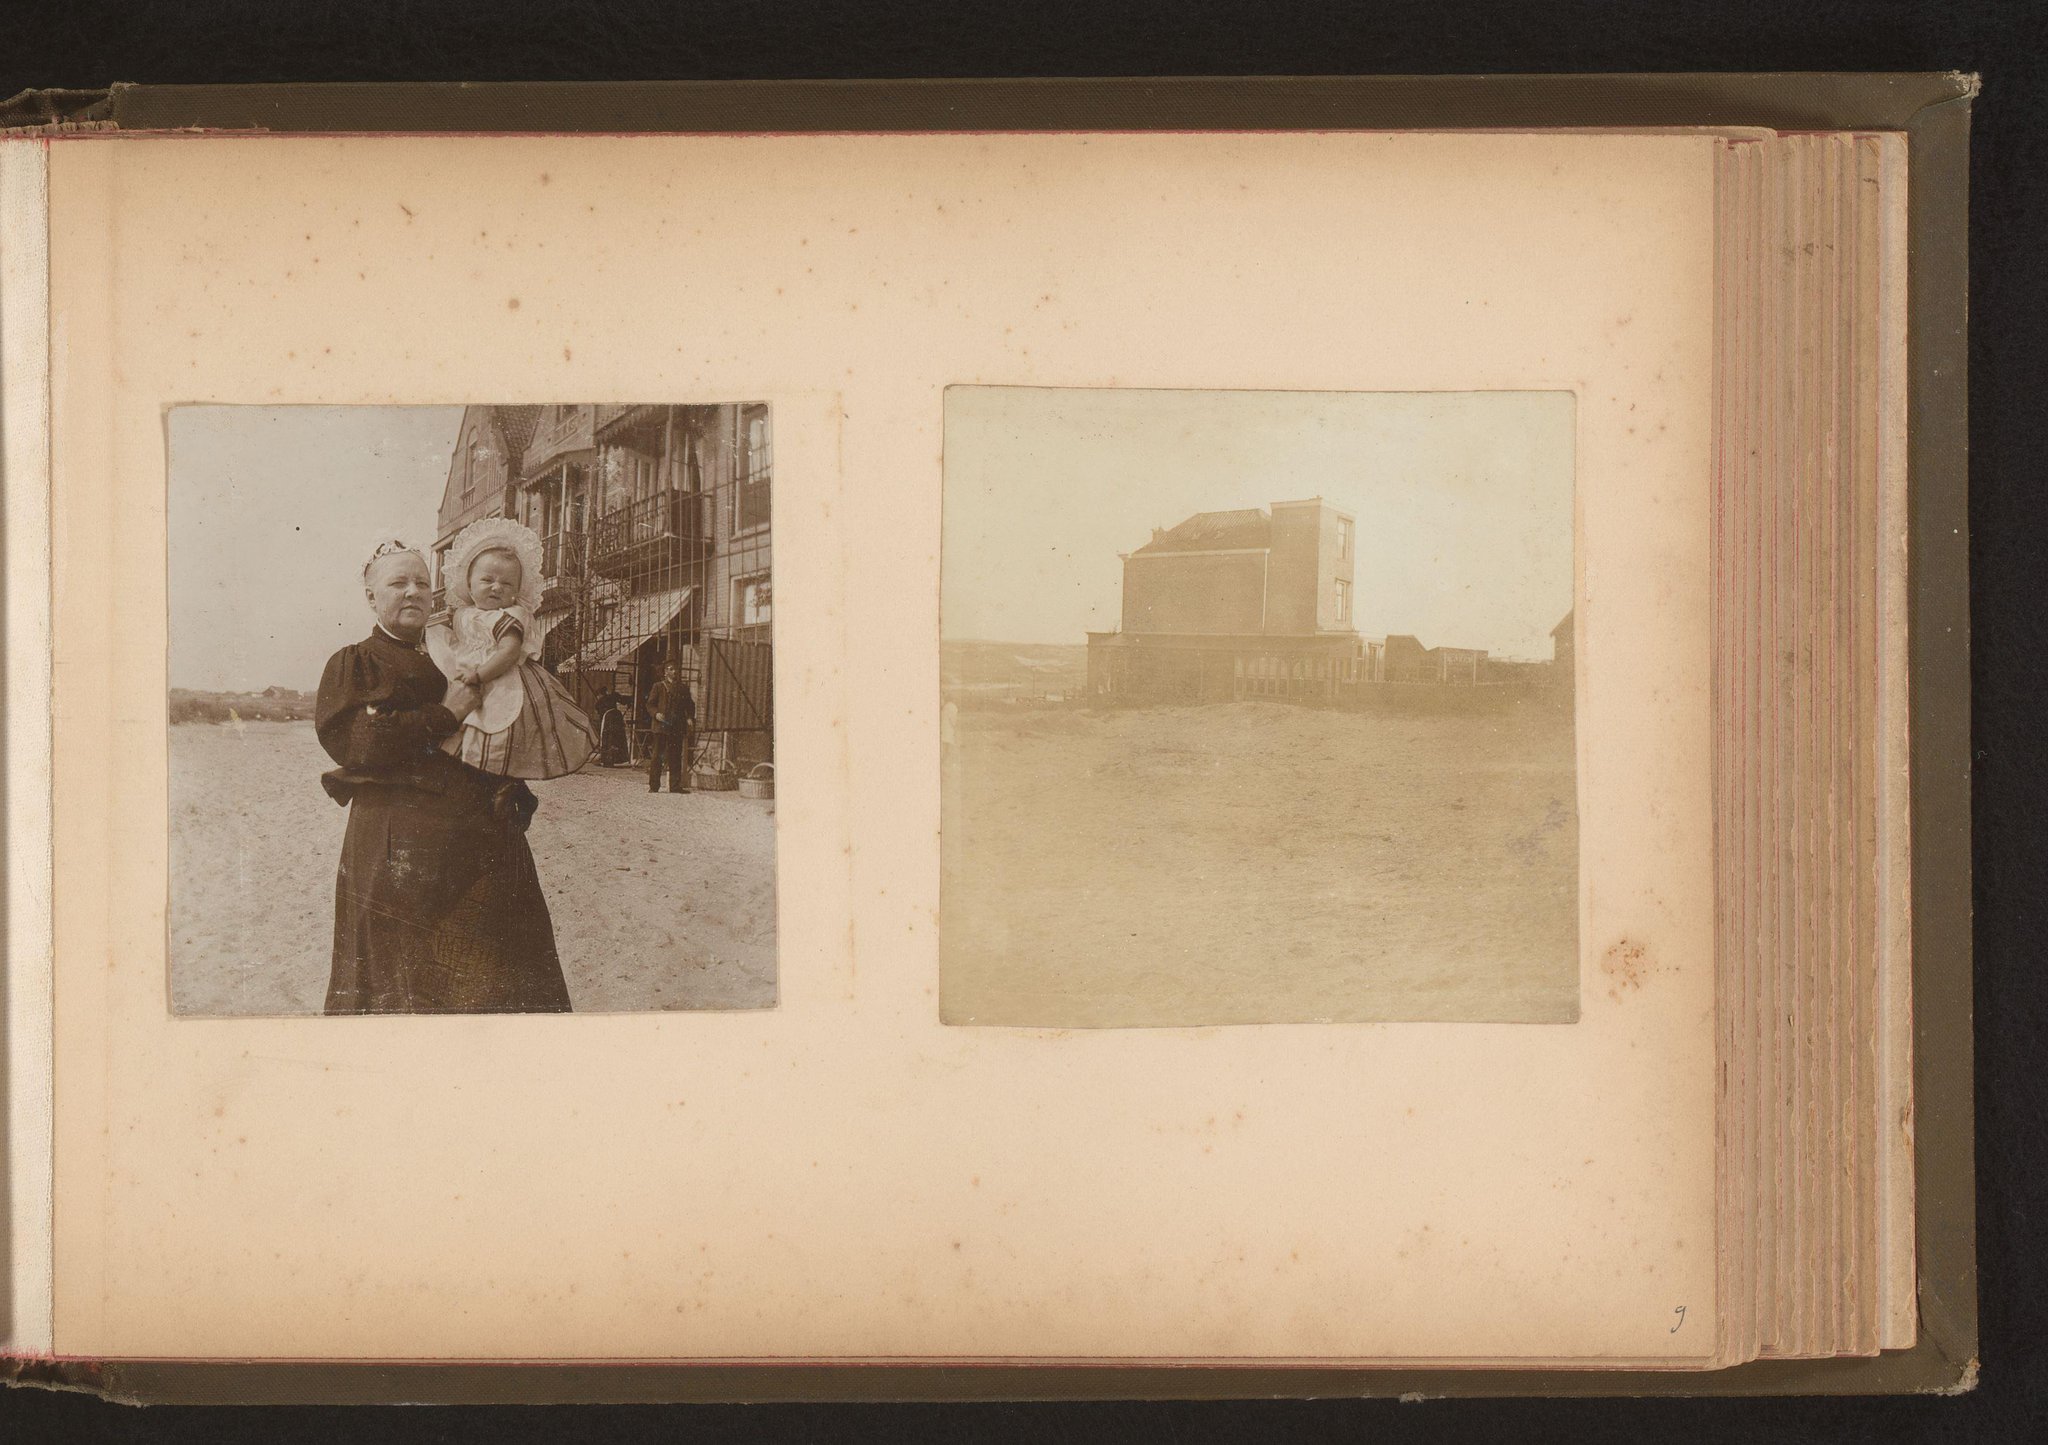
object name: photograph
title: Twee foto's van een vrouw met een kind en een huis in de duinen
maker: Anonymous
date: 1895-1910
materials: paper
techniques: albumen print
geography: zandvoort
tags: rural housing, e.g. country-house, villa, cottage, mother and child(ren), woman and child(ren) (family group)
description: Deze foto's maken deel uit van een album.